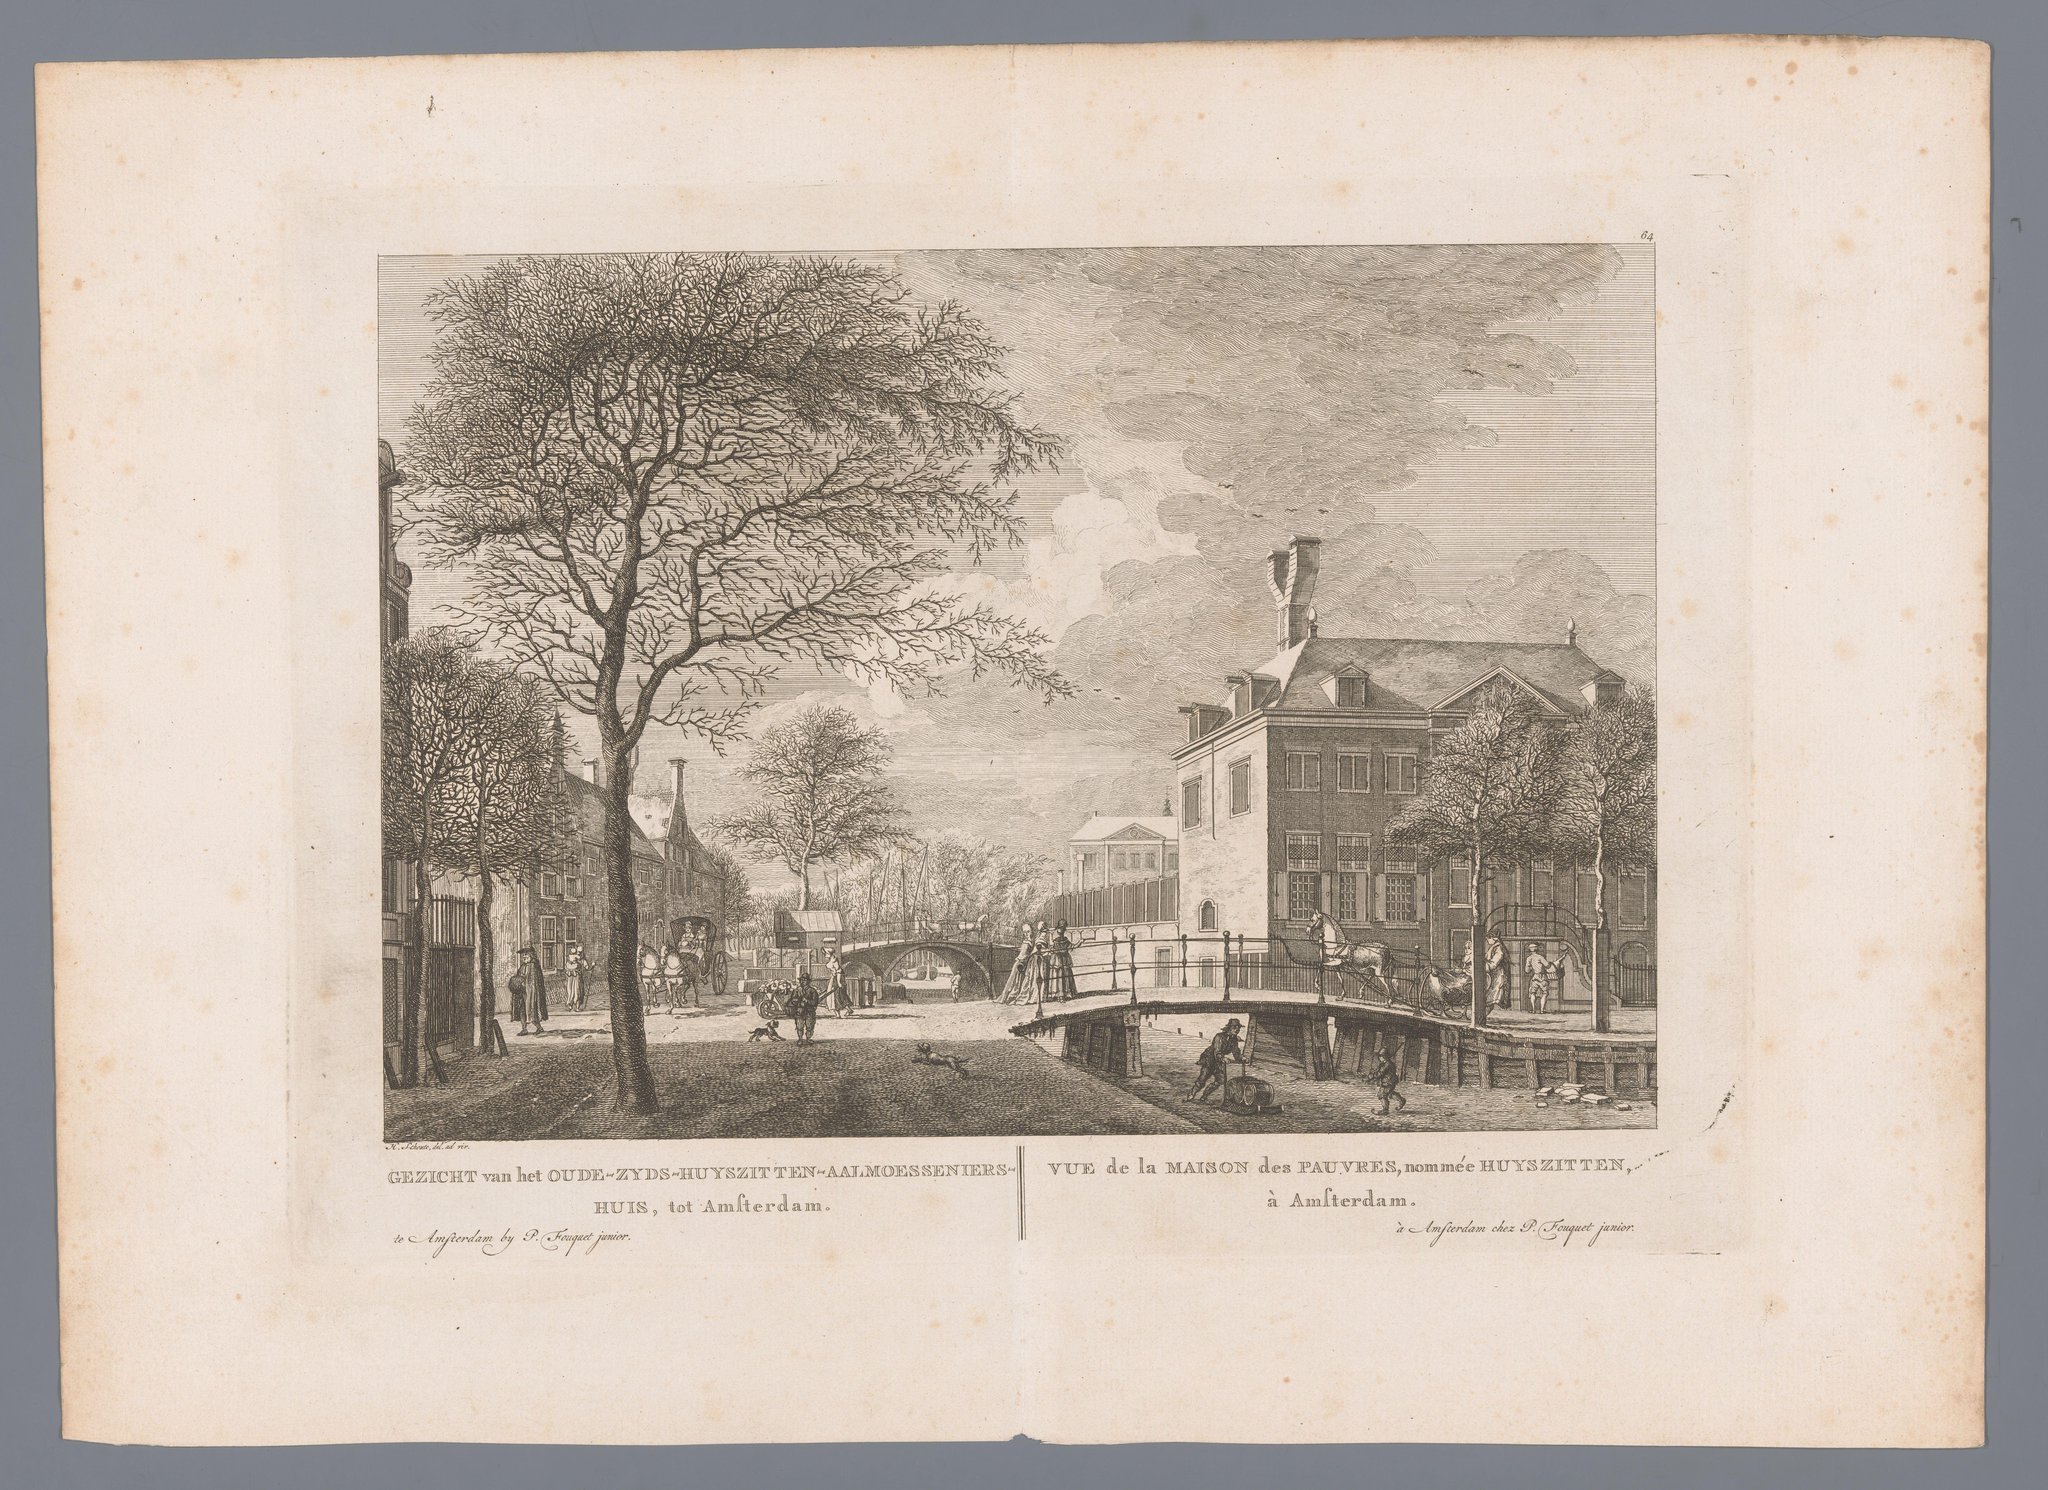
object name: print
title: Gezicht van het Oude-zyds-huyszitten-aalmoesseniers-huis, tot Amsterdam / Vue de la Maison des Pauvres, nommée Huyszitten, à Amsterdam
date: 1778-1783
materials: paper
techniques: engraving, etching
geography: amsterdam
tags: alms-house (dutch: 'hofje')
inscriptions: collector's mark: Lugt 2228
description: Prent uit een van de edities van de Atlas Fouquet: Afbeeldingen van de wyd-vermaarde koopstad Amsterdam benevens des zelvs voornaamste gebouwen en gezigten alle naar het leeven getekend / Receuil des edifices les plus considerables et des plus belles vues, de la fameuse ville d'Amsterdam, dessinées d'après nature. Amsterdam: Pierre Fouquet, 1778-1783. En: Nieuwe atlas, van de voornaamste gebouwen en gezigten der stad Amsterdam, met derzelver beknopte beschryvingen. 2 dln. Amsterdam: Daniël Jean Changuion en Petrus den Hengst [in opdracht van Pierre Fouquet], 1783. Een latere staat komt voor in: Nieuwe atlas, van de voornaamste gebouwen en gezigten der stad Amsterdam. Met derzelver beknopte beschryvingen. Amsterdam: Evert Maaskamp, 1805.